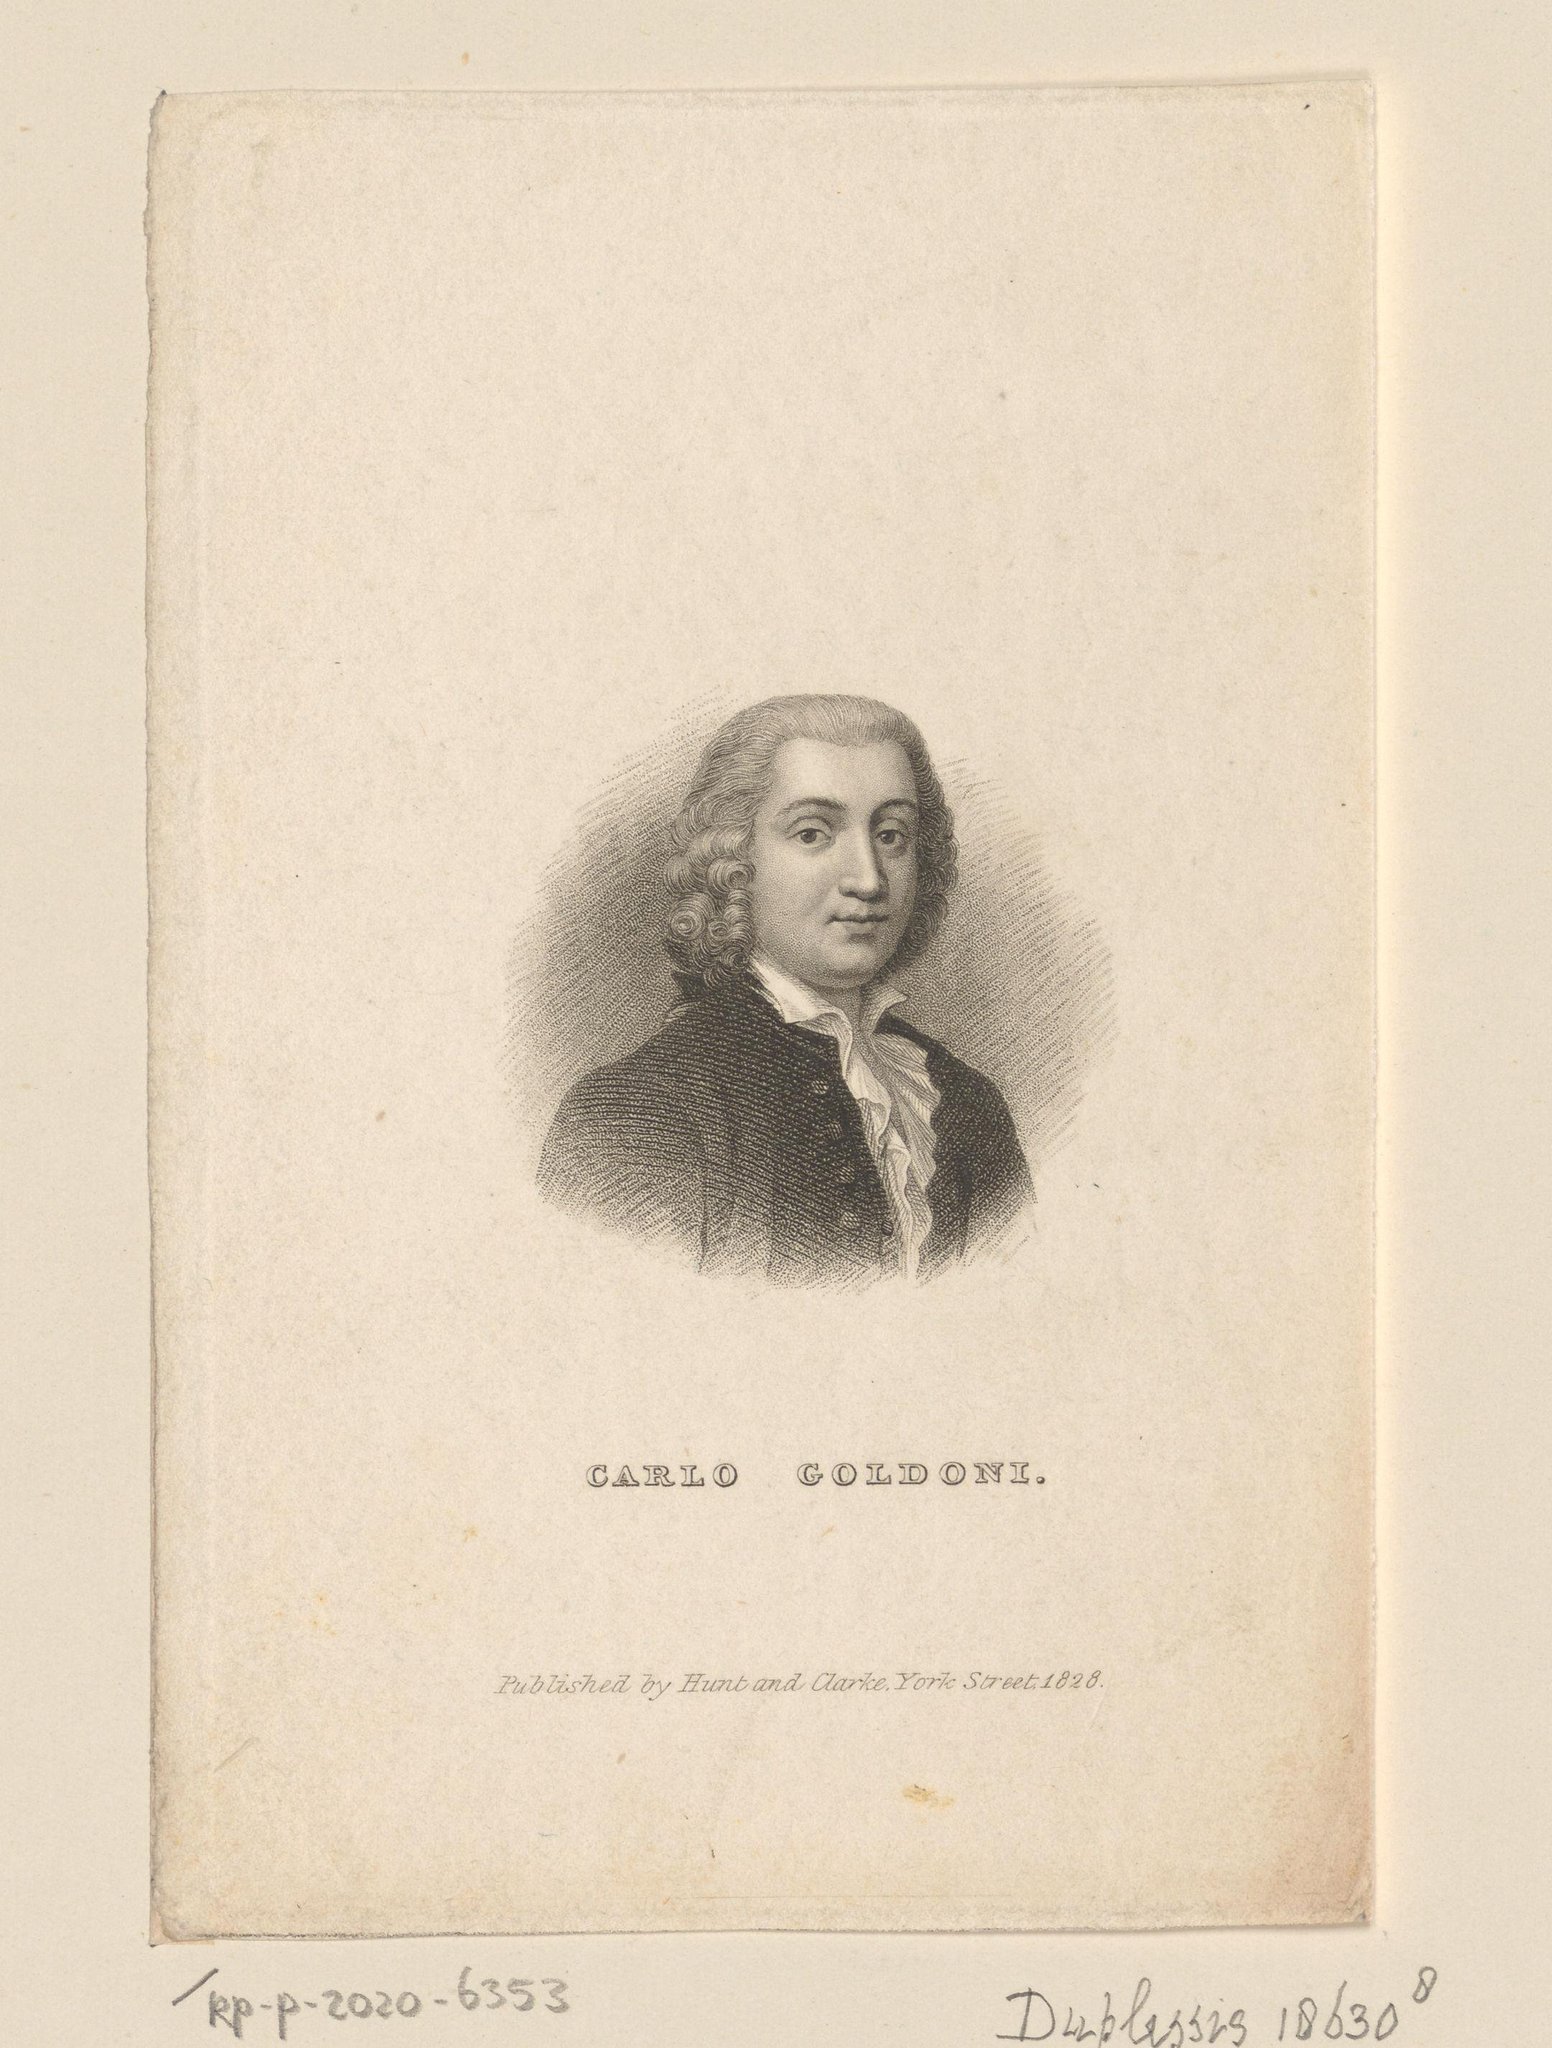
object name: print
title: Portret van Carlo Goldoni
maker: Anonymous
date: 1828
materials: paper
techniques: engraving, etching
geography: london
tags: venice, paris, carlo goldoni, historical persons, writer, poet, author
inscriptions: date